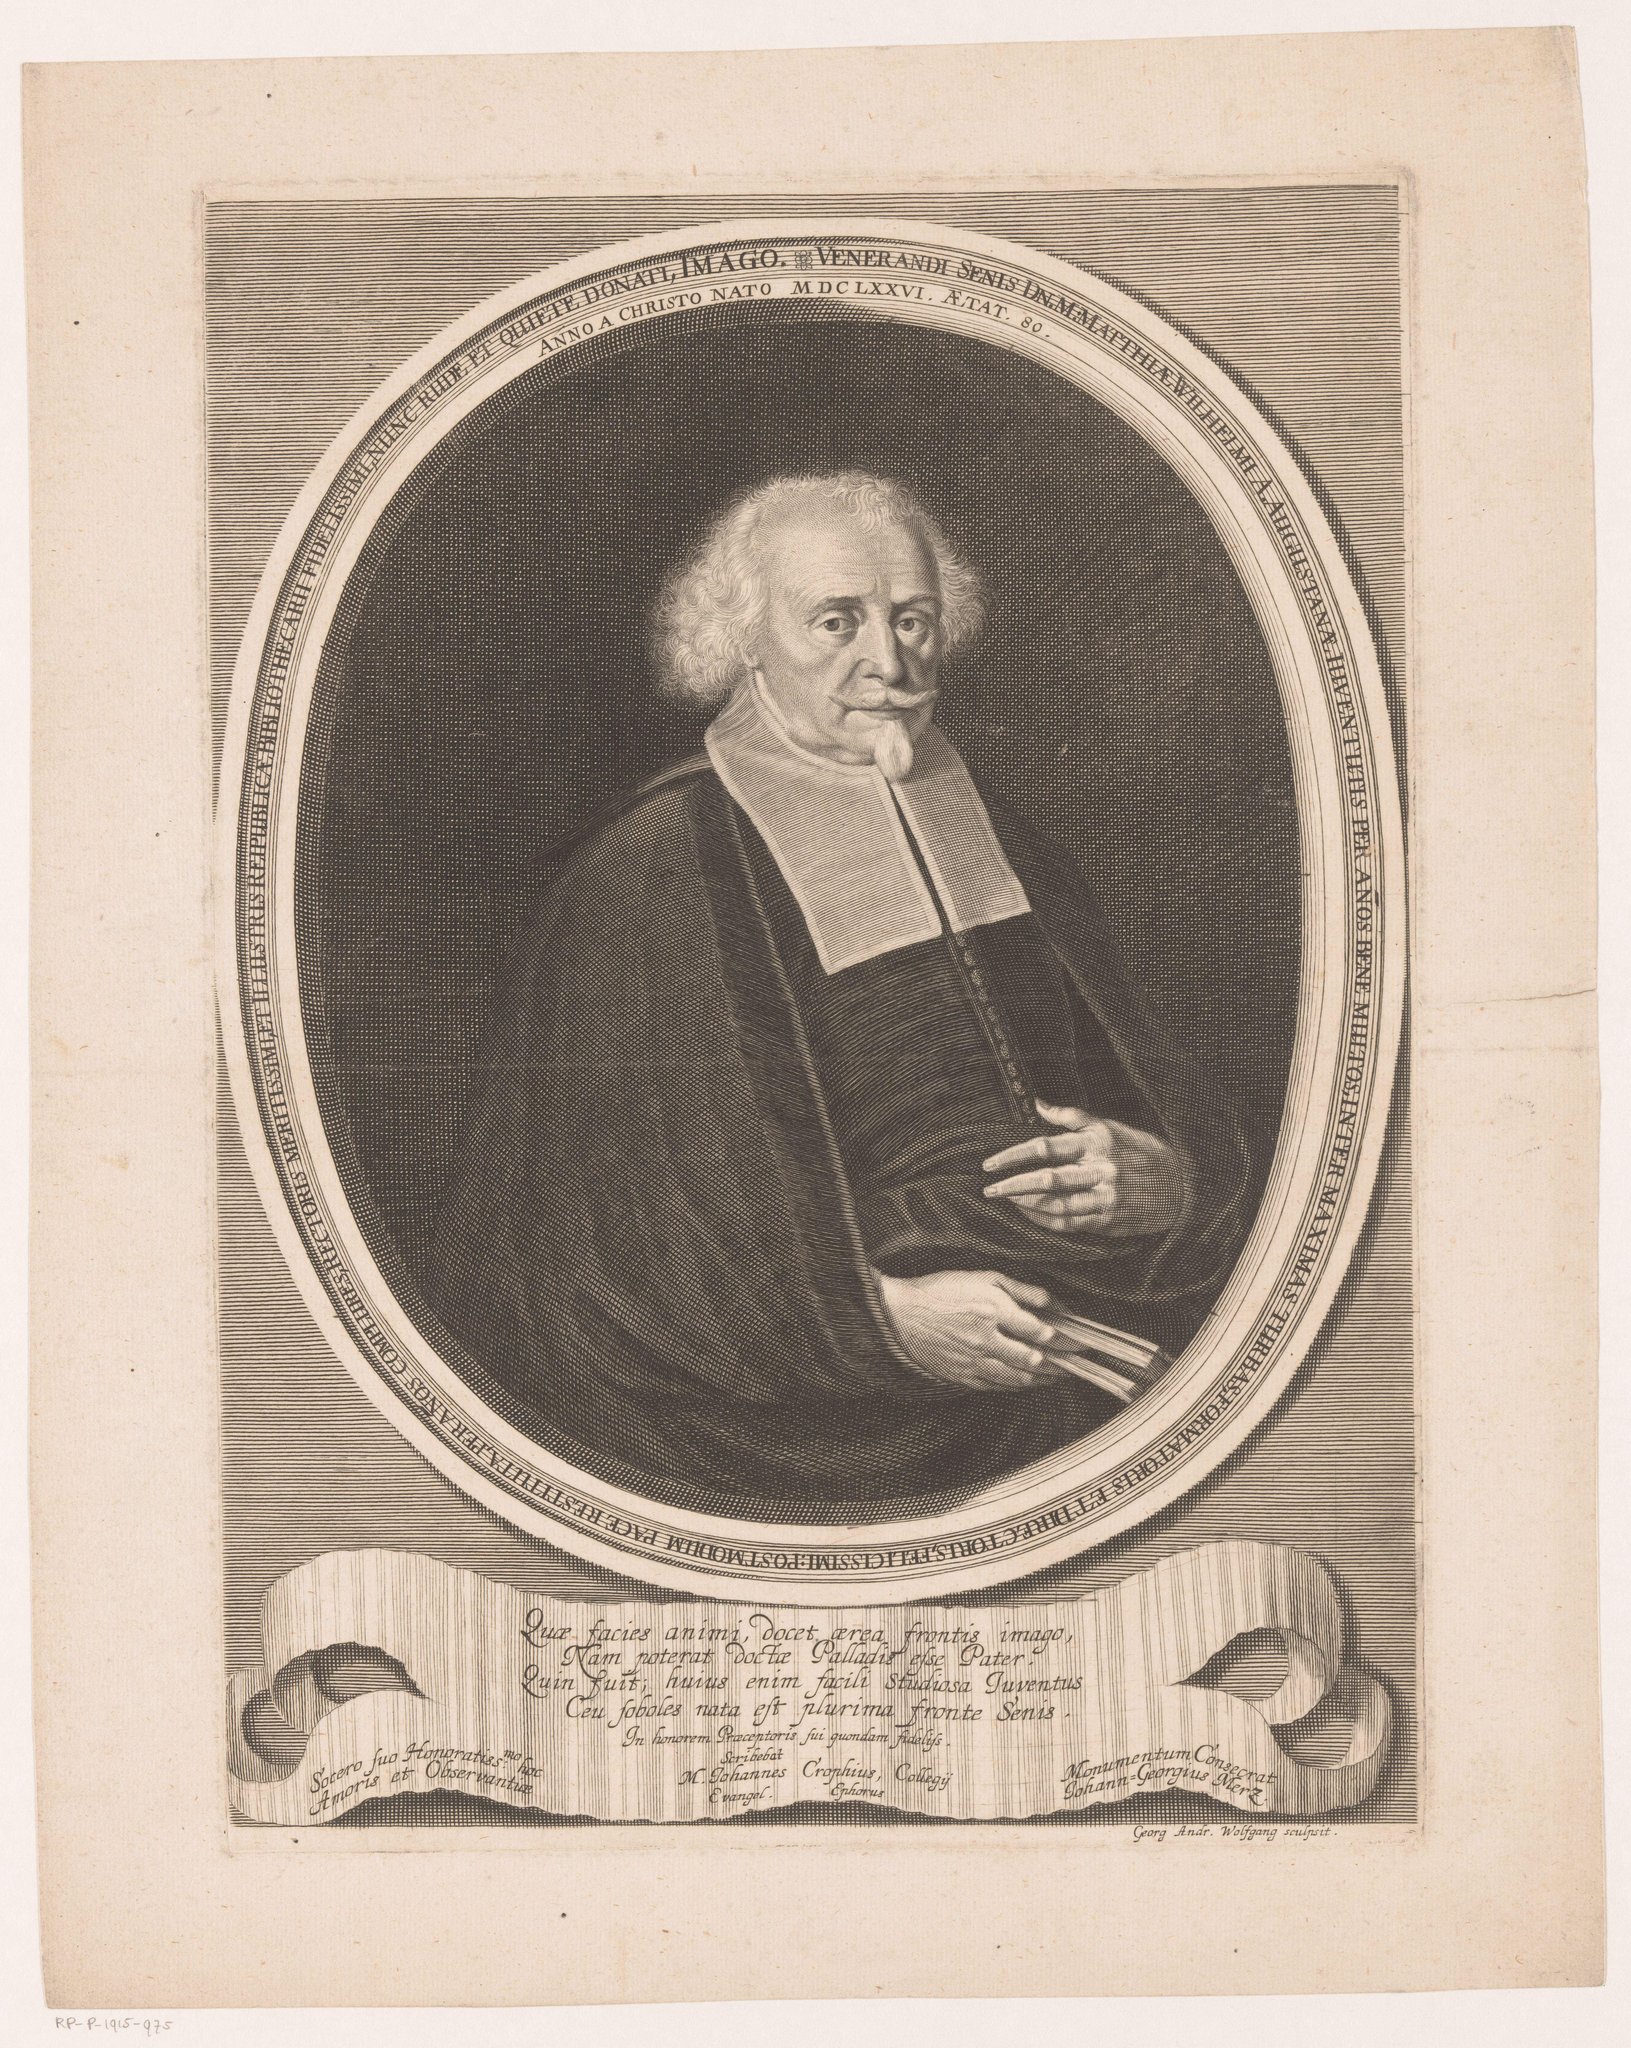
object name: print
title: Portret van Matthias Wilhelm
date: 1676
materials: paper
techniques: engraving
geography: germany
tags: historical persons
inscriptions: collector's mark: Lugt 2228